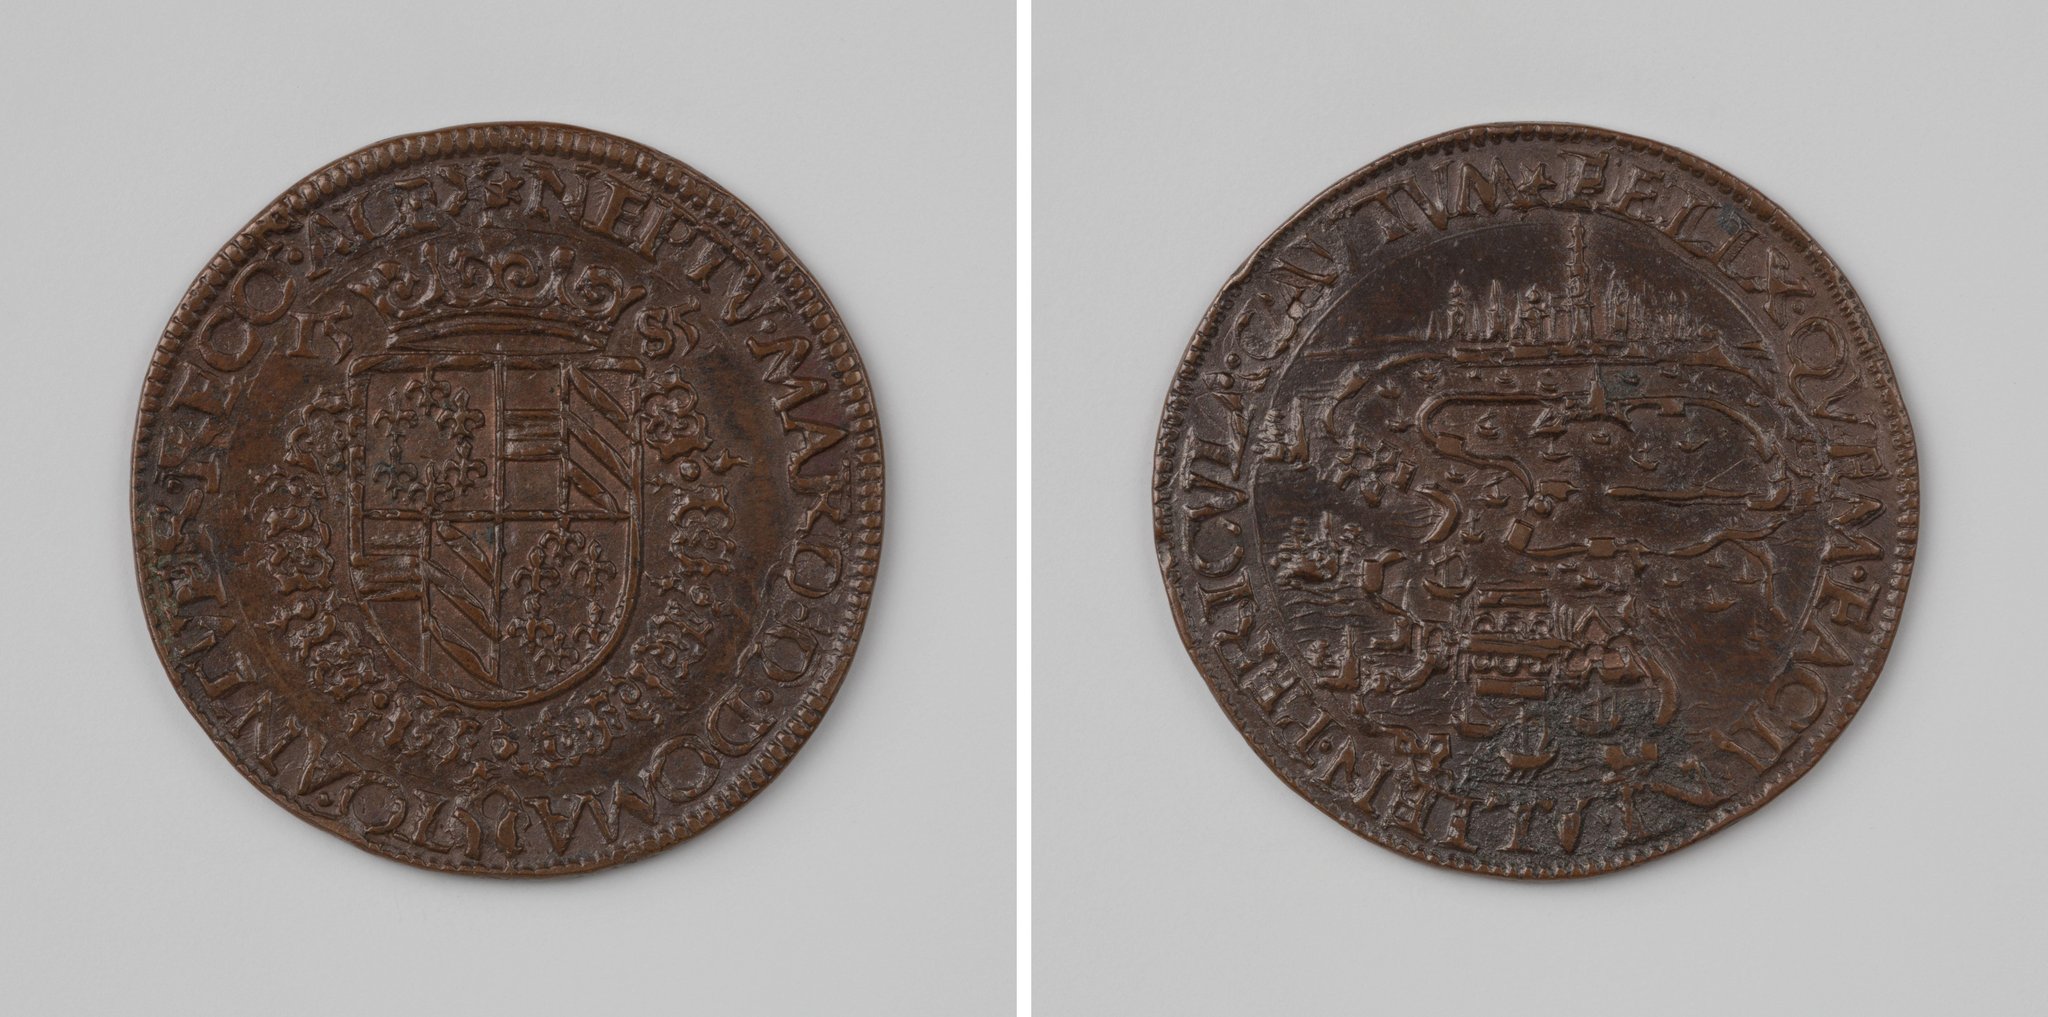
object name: jeton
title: Inname van Antwerpen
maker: Anonymous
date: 1585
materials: copper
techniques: striking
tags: vienna, albert casimir van saksen-teschen, rome, alessandro farnese (landvoogd van de nederlanden en hertog van parma en piacenza), antwerp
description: Koperen penning. Voorzijde: gekroond wapenschild, omhangen met de orde van het Gulden Vlies binnen omschrift. Keerzijde: gezicht op stad Antwerpen, schipbrug, schansen en onder water staande land binnen omschrift